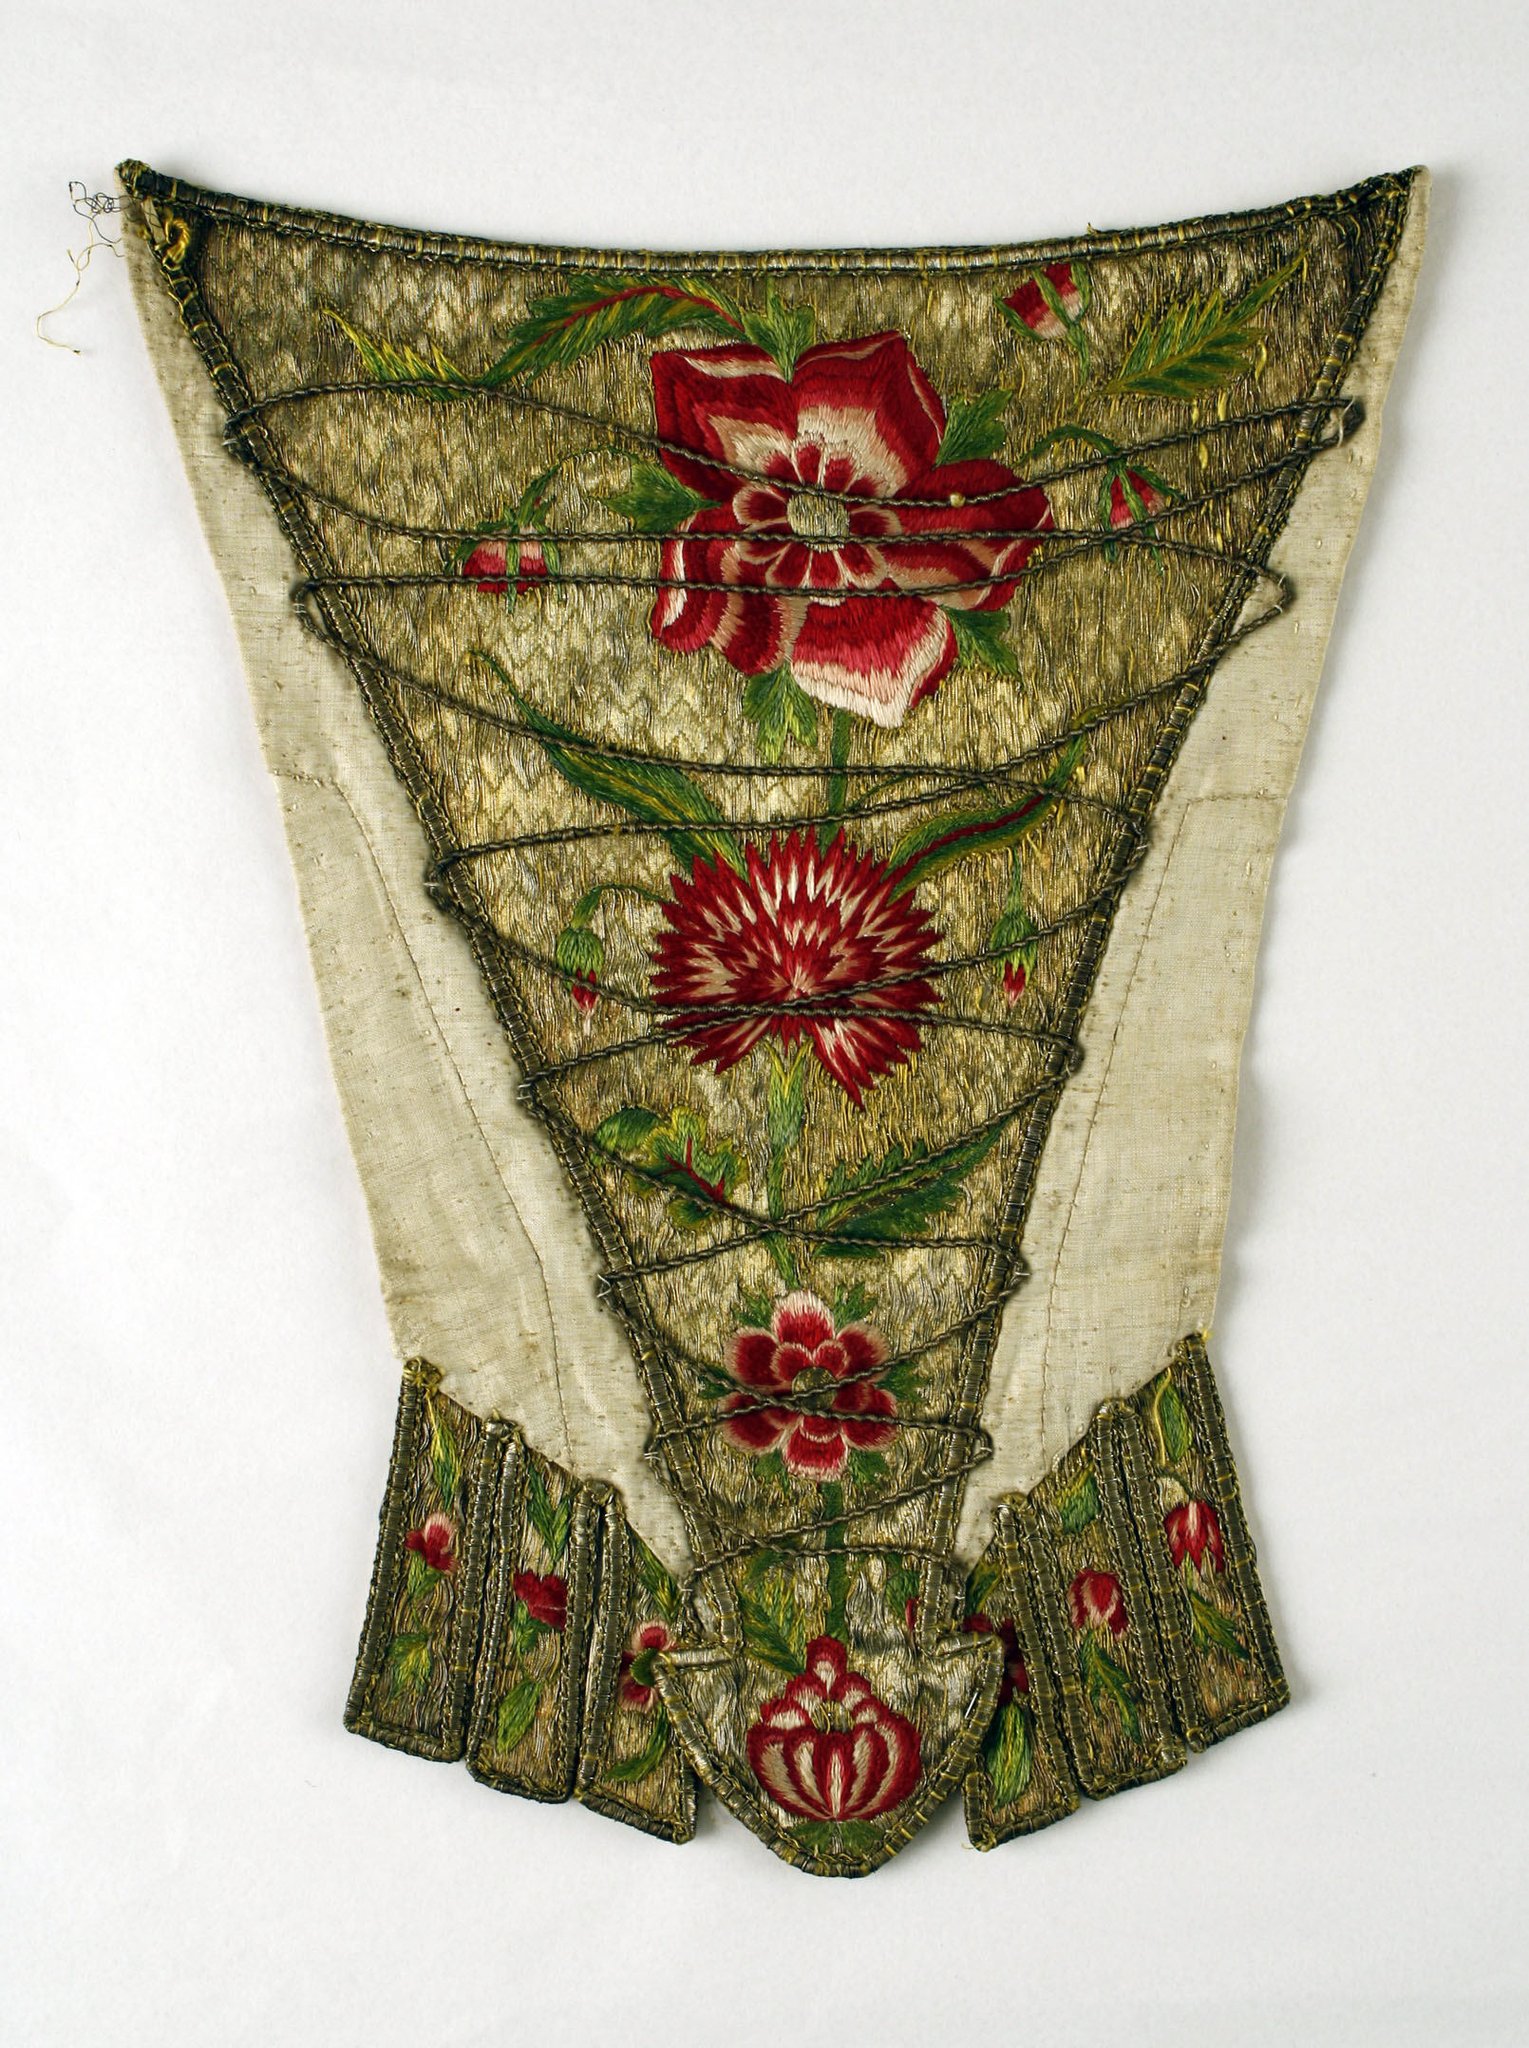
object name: stomacher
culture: british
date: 1720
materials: metal, silk